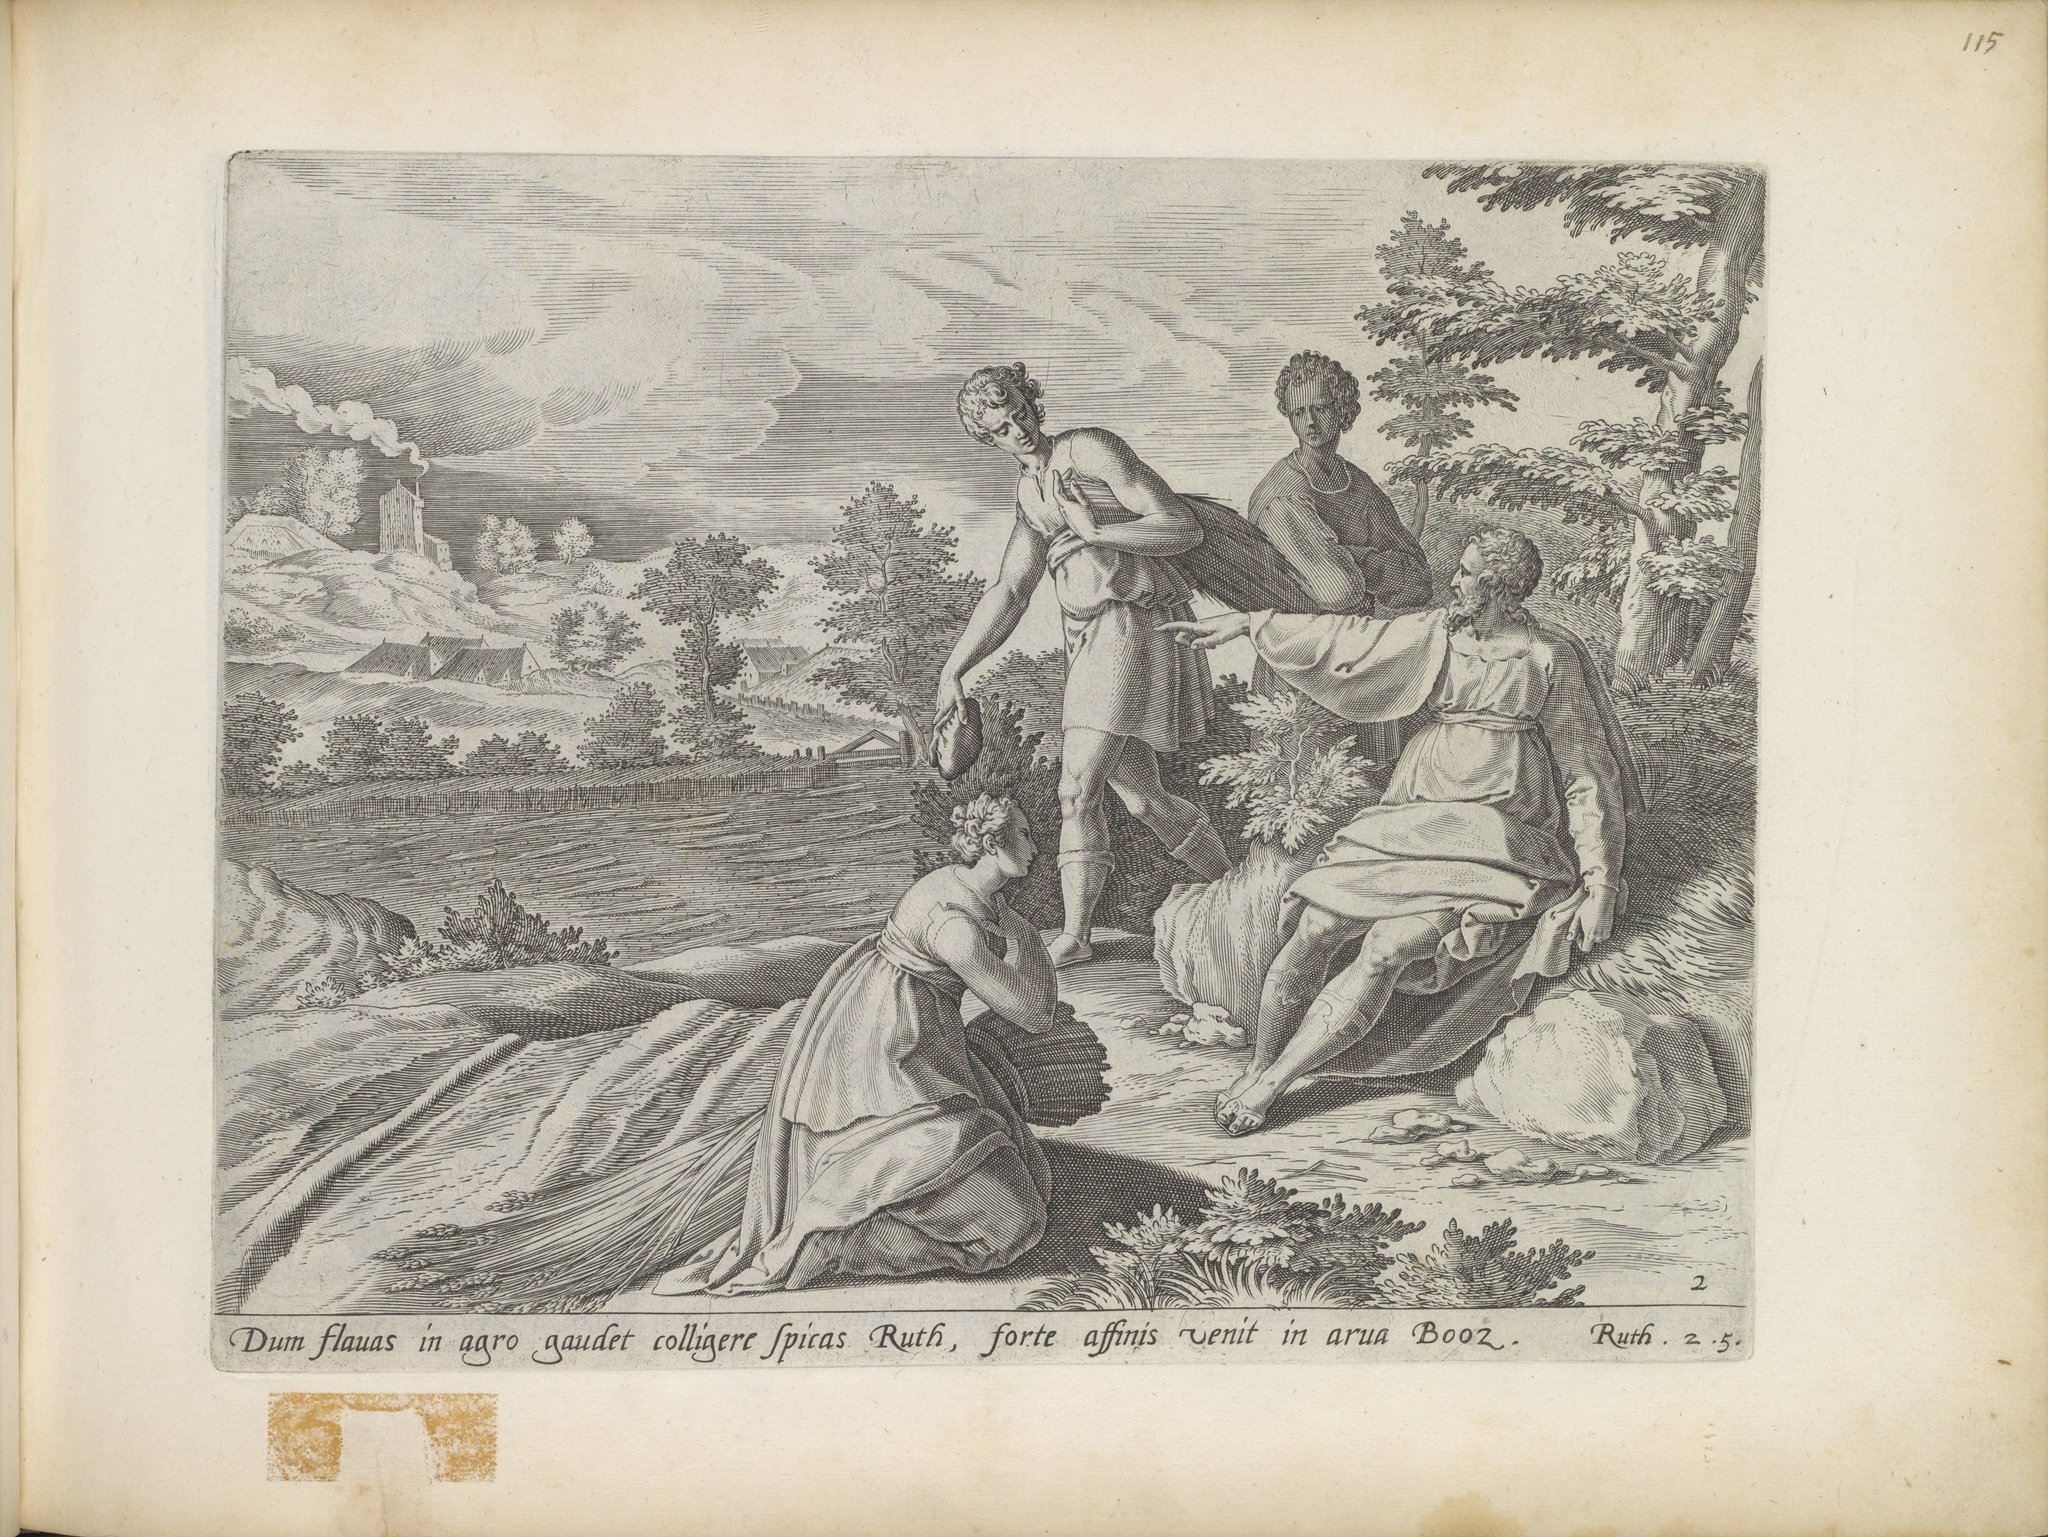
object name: album leaf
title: Geschiedenis van Ruth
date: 1579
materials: paper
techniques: engraving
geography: amsterdam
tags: boaz speaks to ruth; ruth usually bowing down, or kneeling before him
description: Boaz spreekt met Ruth, die op zijn akker aren heeft geraapt. Ruth knielt voor hem met een bundel aren onder de arm. Boaz wijst op zijn akker en zegt dat ze aren mag blijven rapen. Onder de voorstelling een verwijzing in het Latijn naar de Bijbeltekst in Ruth 2:5. Deze prent maakt deel uit van een album.